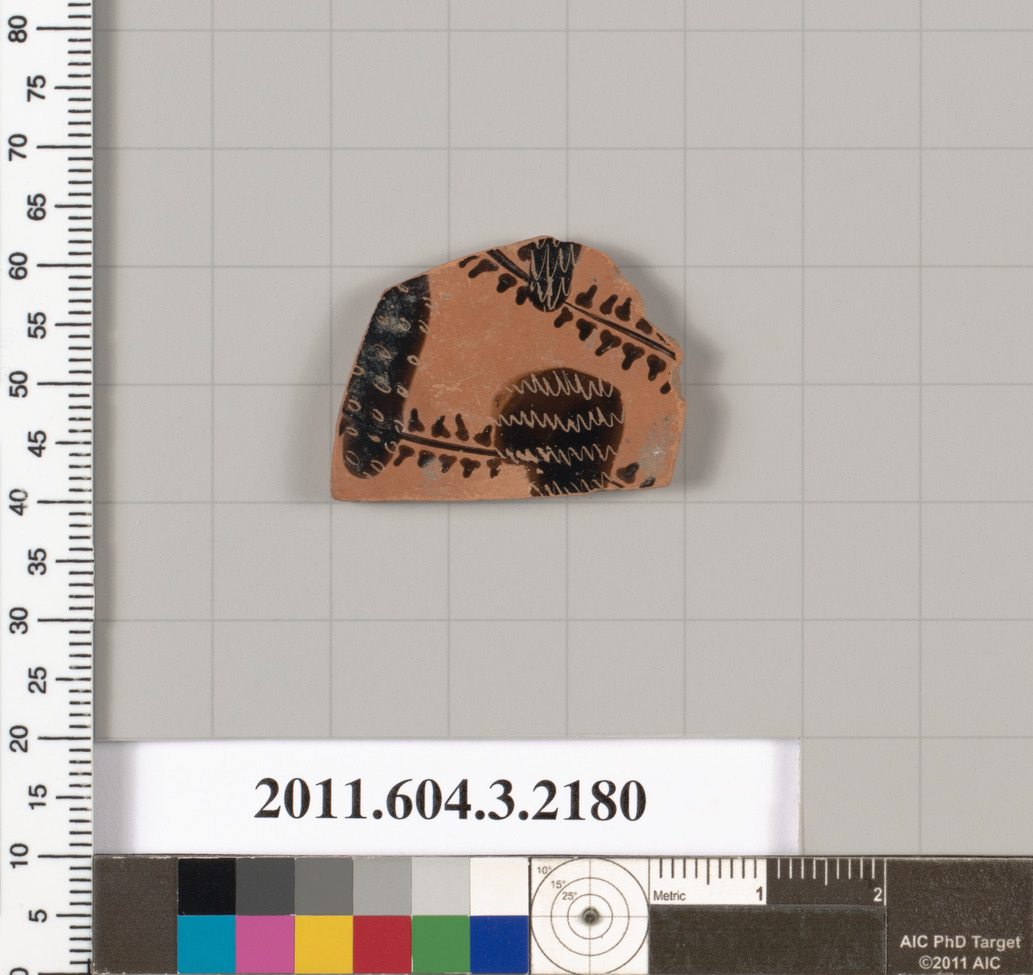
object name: kylix fragment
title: Terracotta fragment of a kylix (drinking cup)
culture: greek, attic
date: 540-530 BCE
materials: terracotta